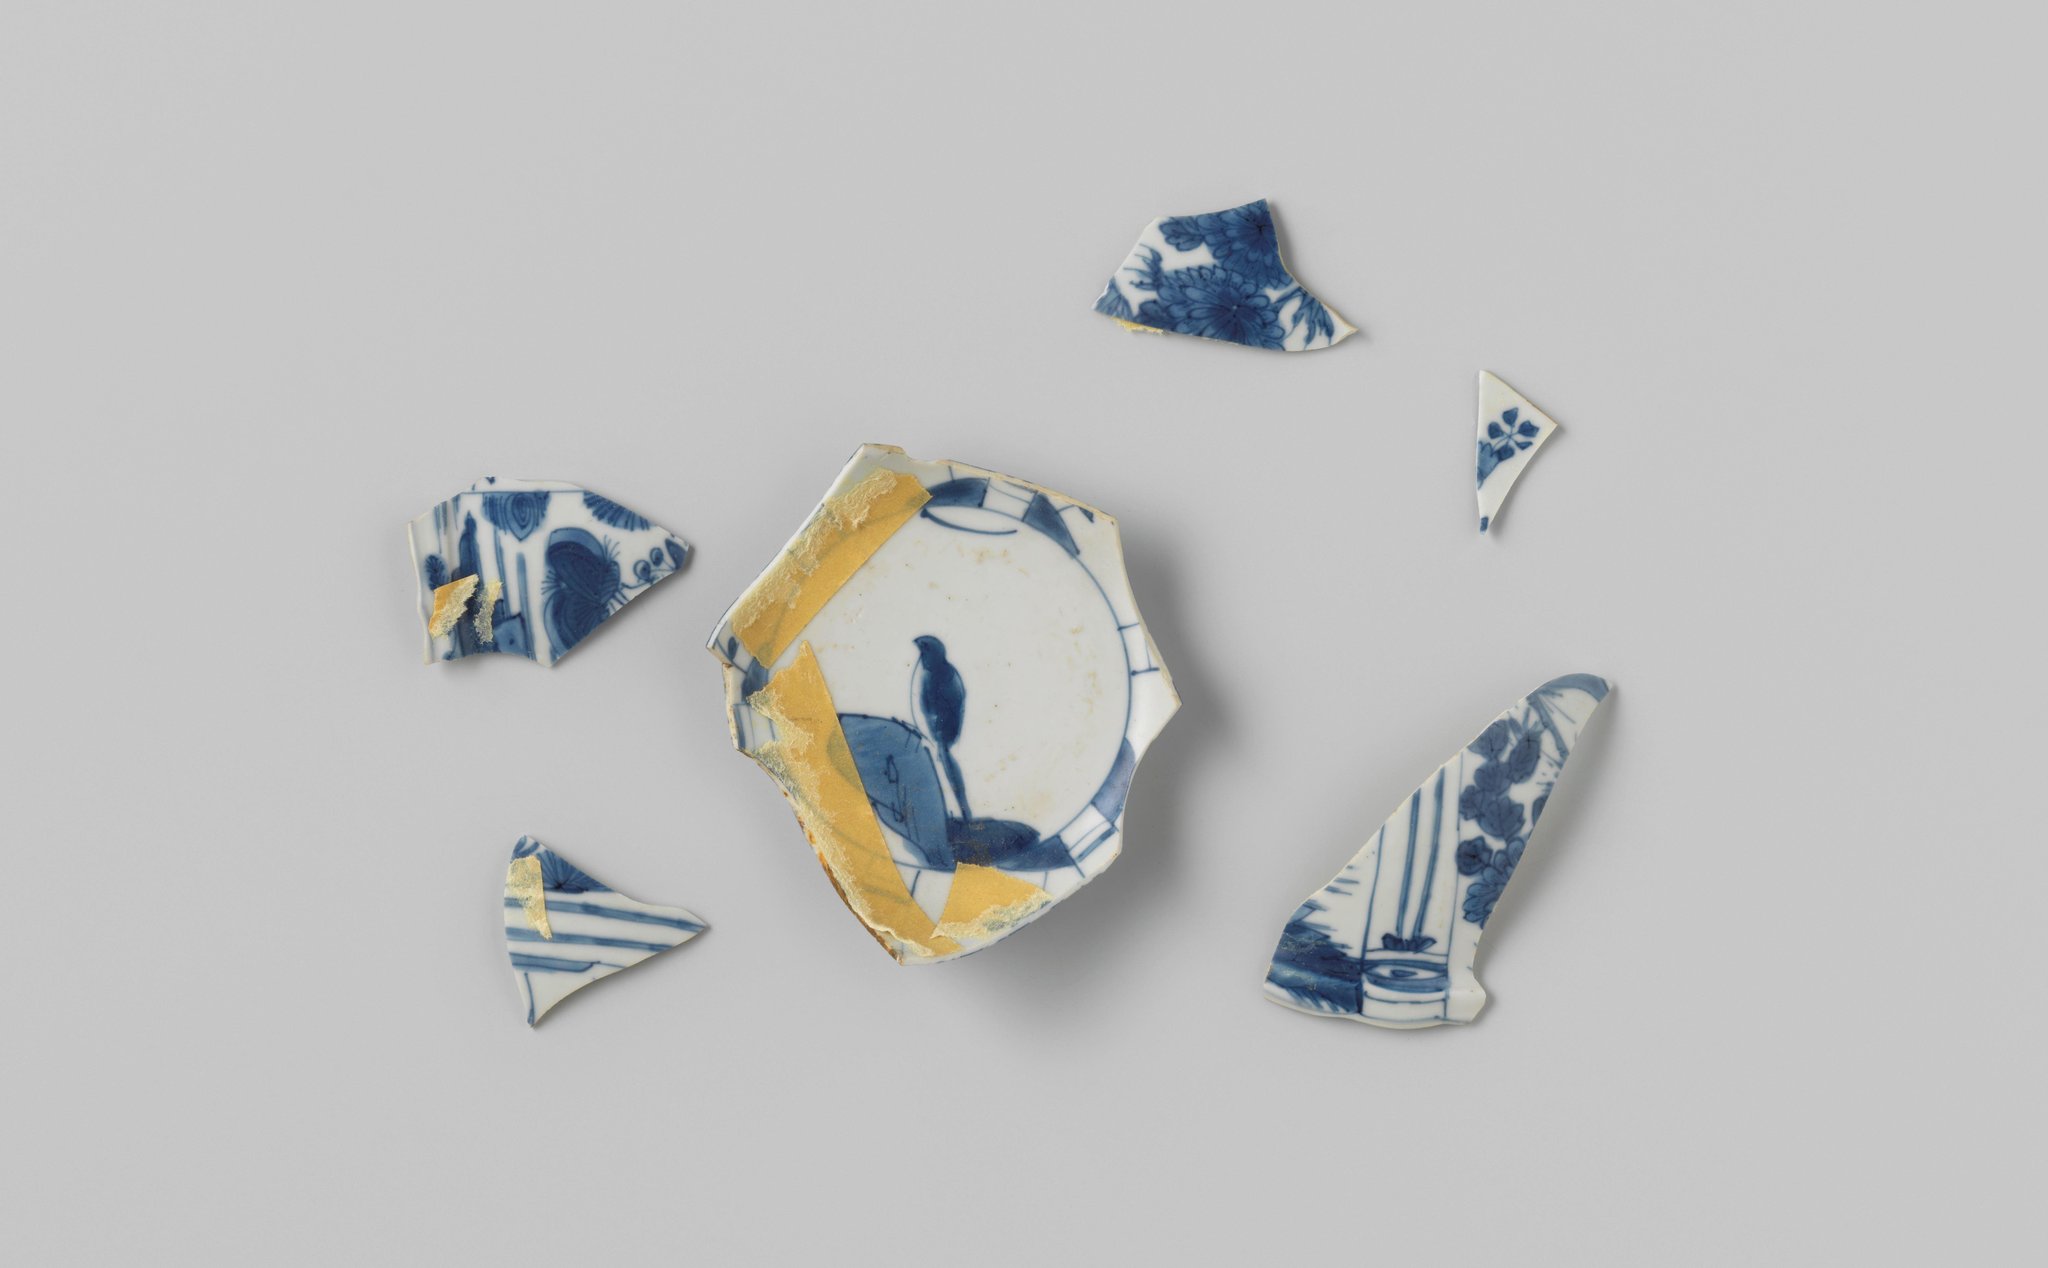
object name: kraaikop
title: Scherven van een kraaikop uit V.O.C.-schip de 'Witte Leeuw'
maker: Anonymous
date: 1613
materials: bone china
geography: jingdezhen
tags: verenigde oostindische compagnie, sint-helena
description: Scherven van een kraaikop uit V.O.C.-schip de 'Witte Leeuw', 75% aanwezig.